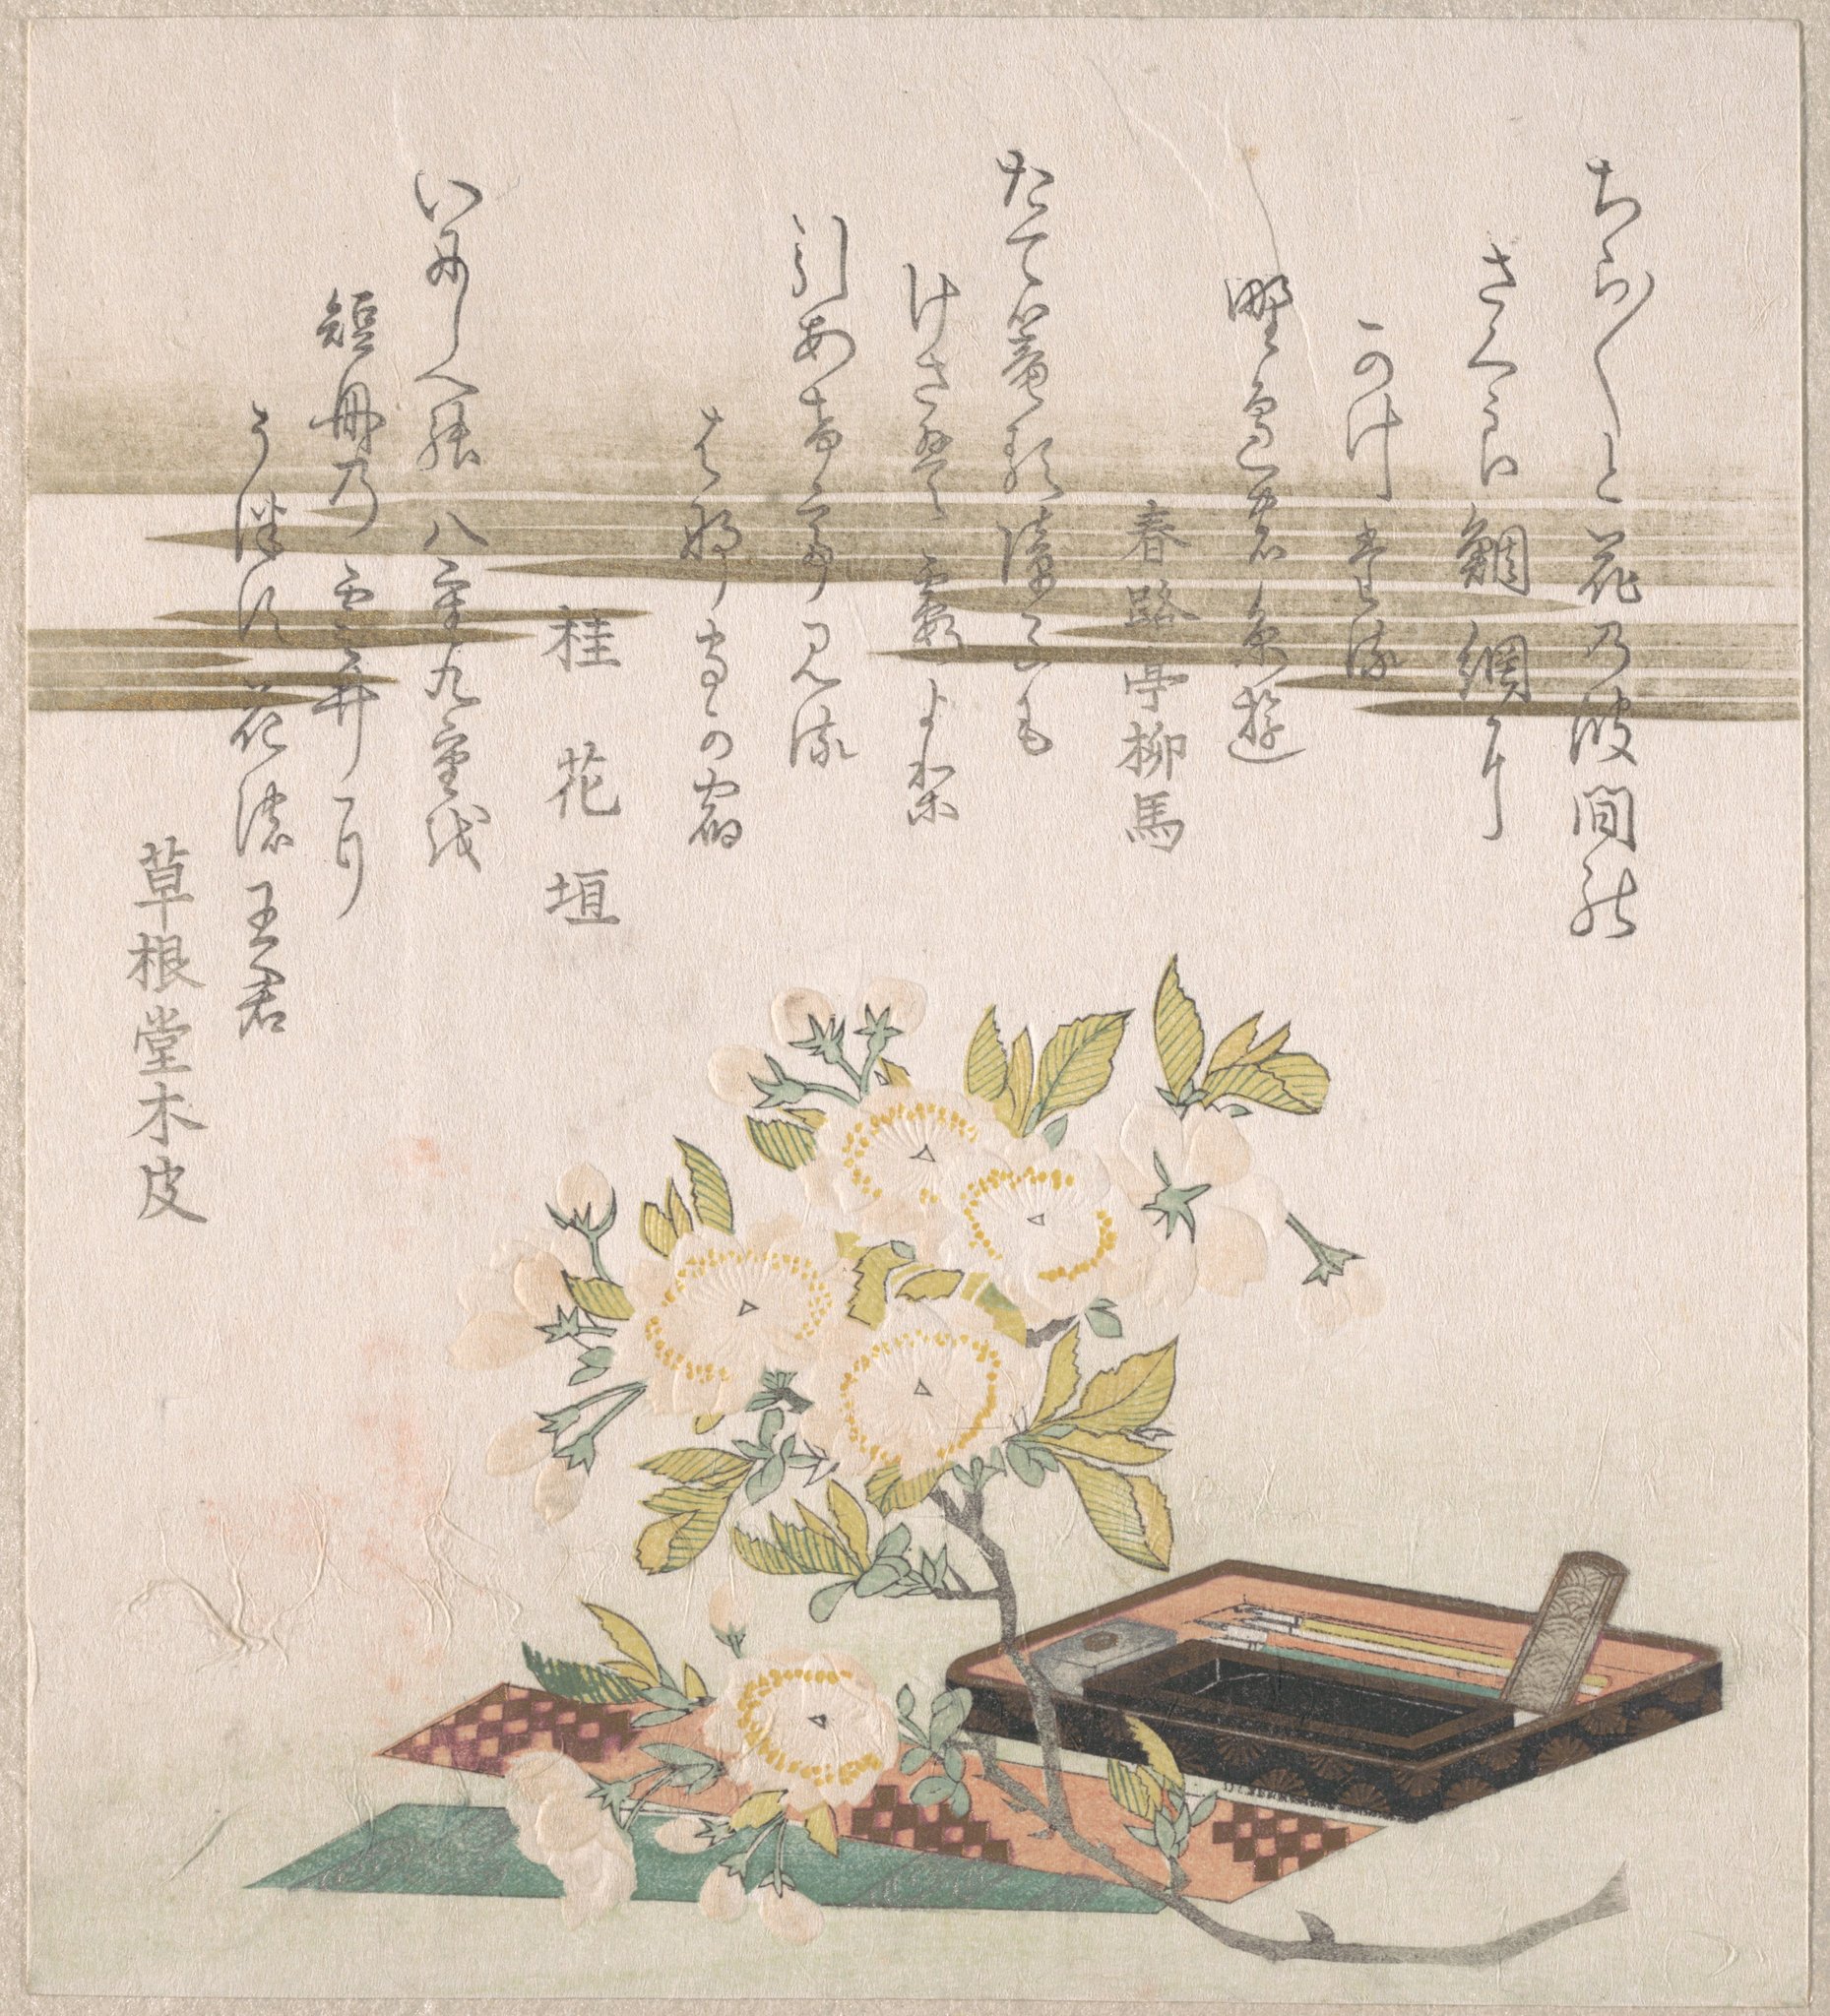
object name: woodblock print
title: Branch with Cherry Flowers, Writing Box and Sheet of Paper for Poem Writing (Tanzaku)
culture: japanese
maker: unidentified artist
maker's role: artist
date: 1768-1868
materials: ink, paper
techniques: surimono, woodblock print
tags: flowers,writing implements